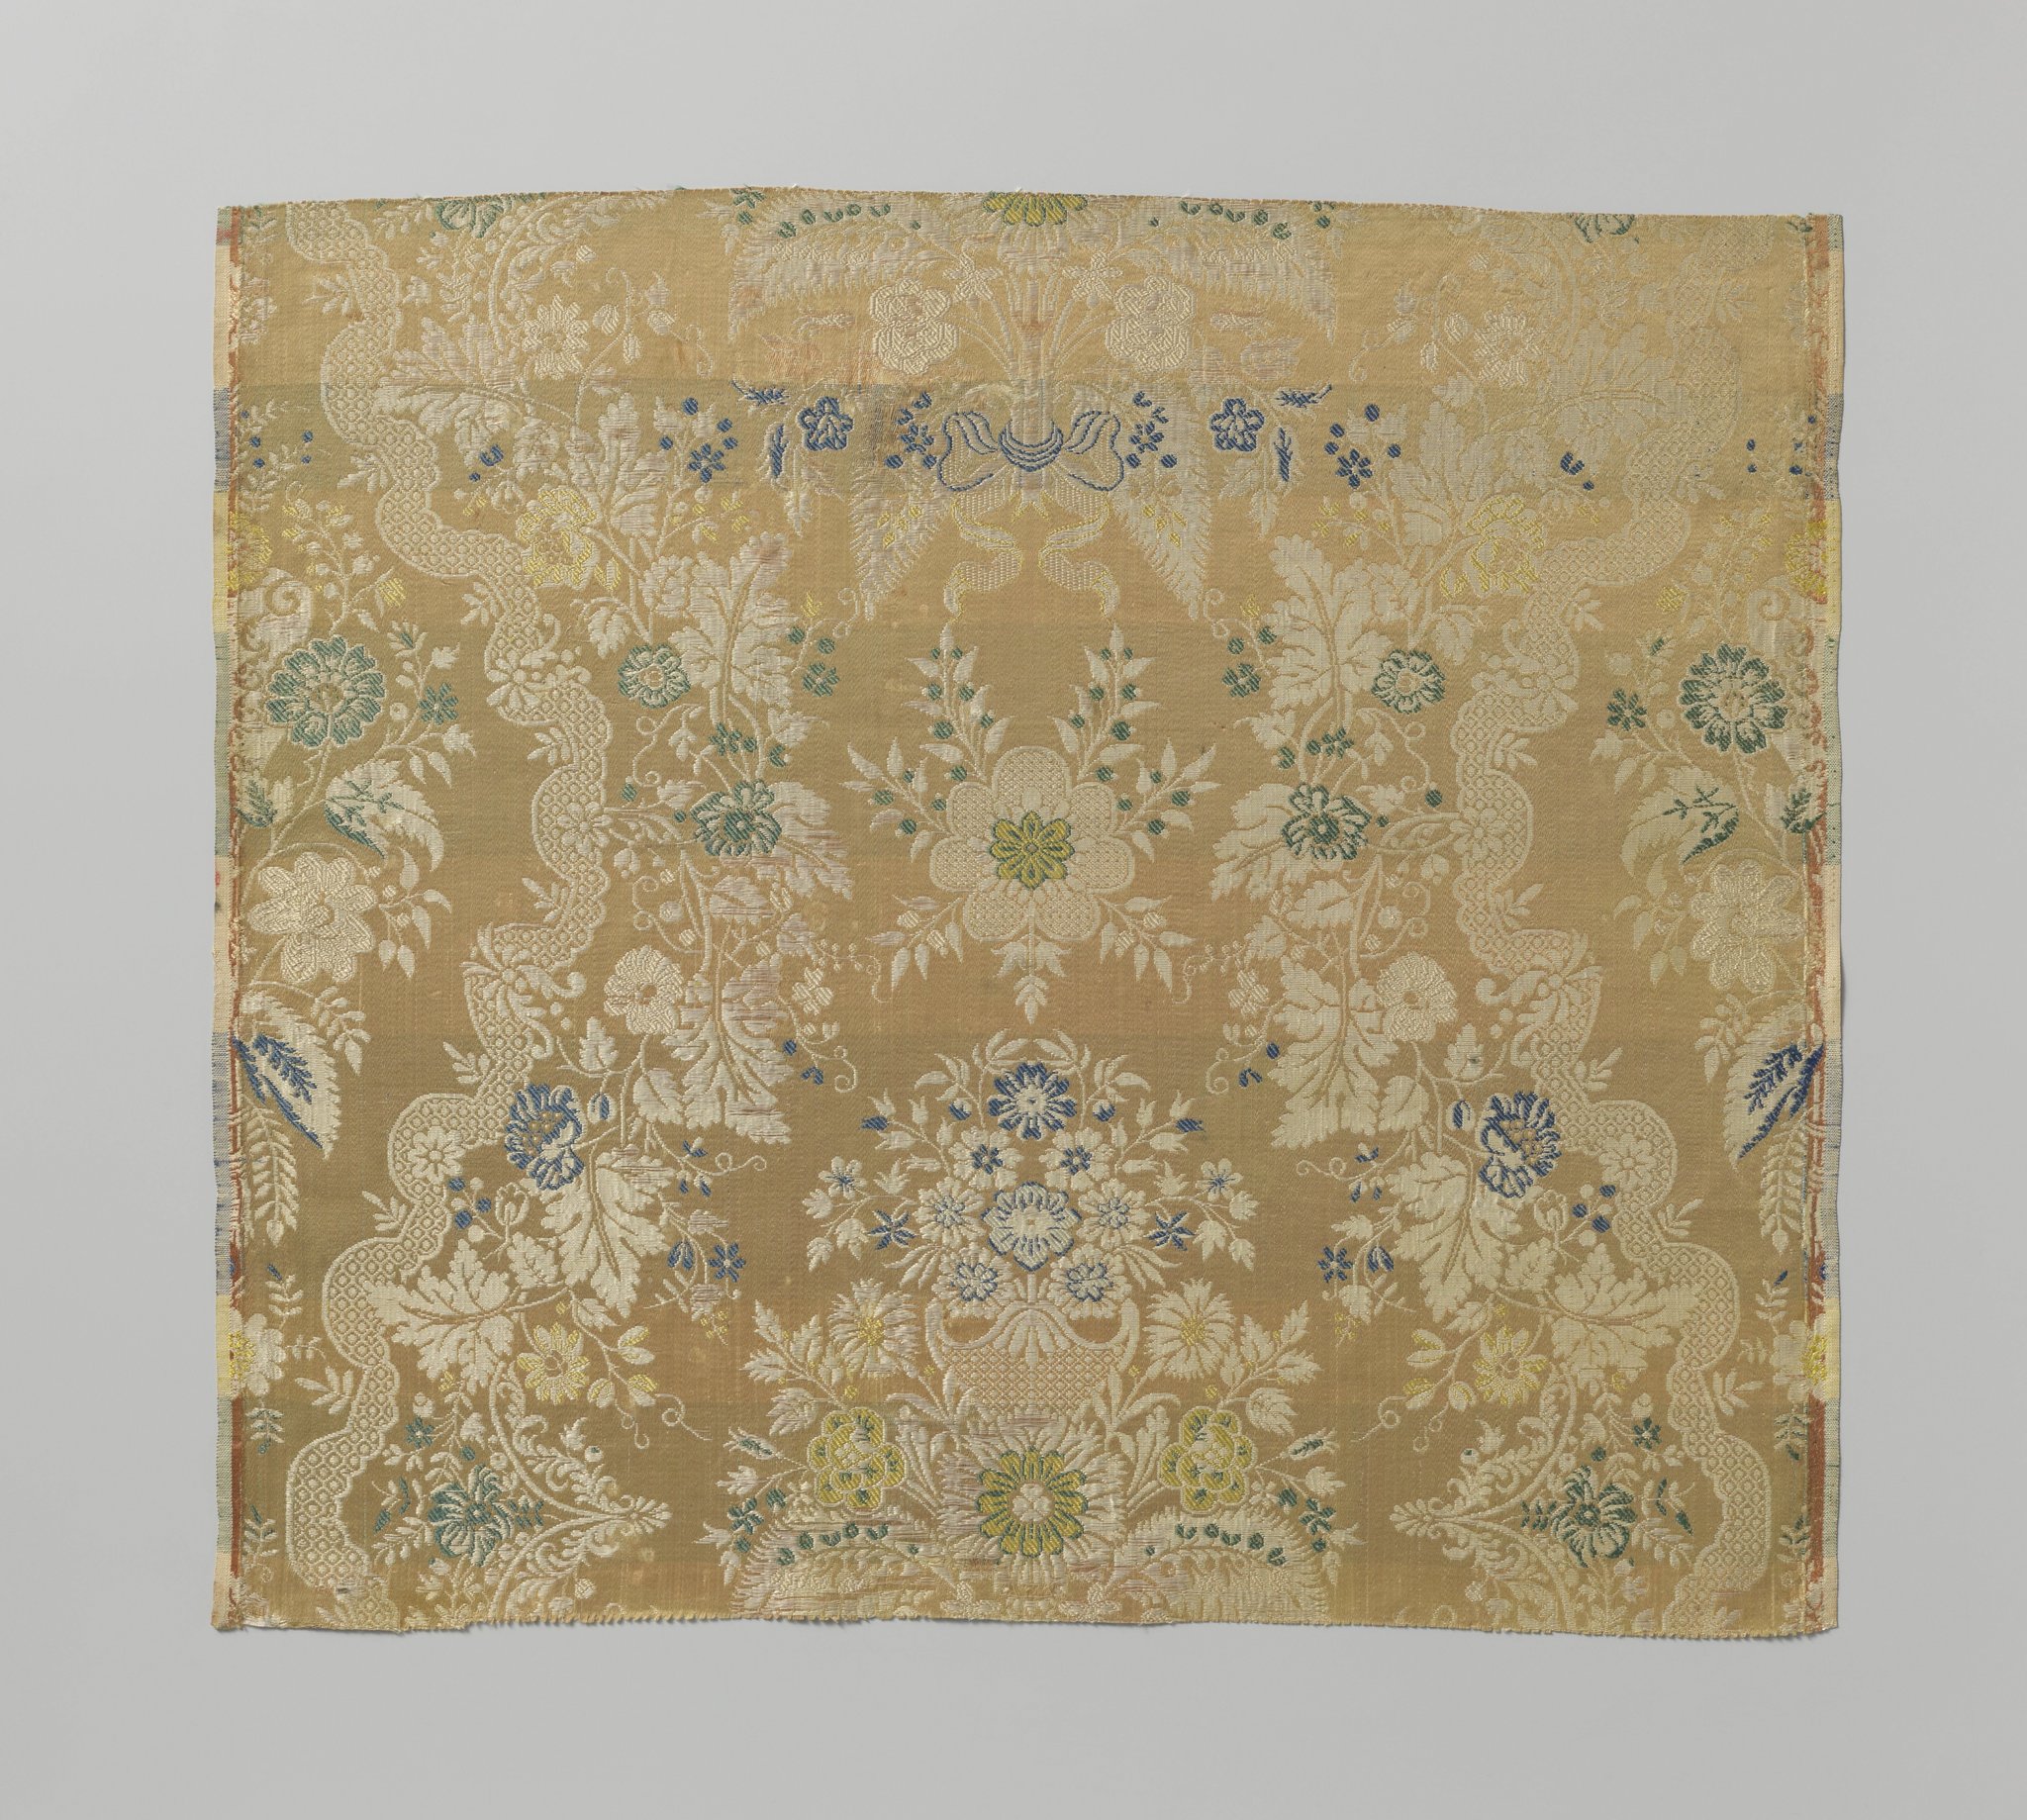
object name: woven material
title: Fragment veelkleurig zijdesatijn met op zalmkleurig fond een patroon van bloemen en bloemtuilen, wijnrank en slingerende kantbanden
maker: Anonymous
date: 1720-1730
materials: silk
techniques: brocade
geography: france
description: Fragment veelkleurig zijdeweefsel, met een okerkleurige grond (verschoten naar zalmkleur). Het patroon heeft kantslingers waarlangs bloemen- en wijnranken. De slingers vormen velden waarin een met kantwerk versierde vaas met een bloemboeket op een rozet met bladereen bloemtakken.